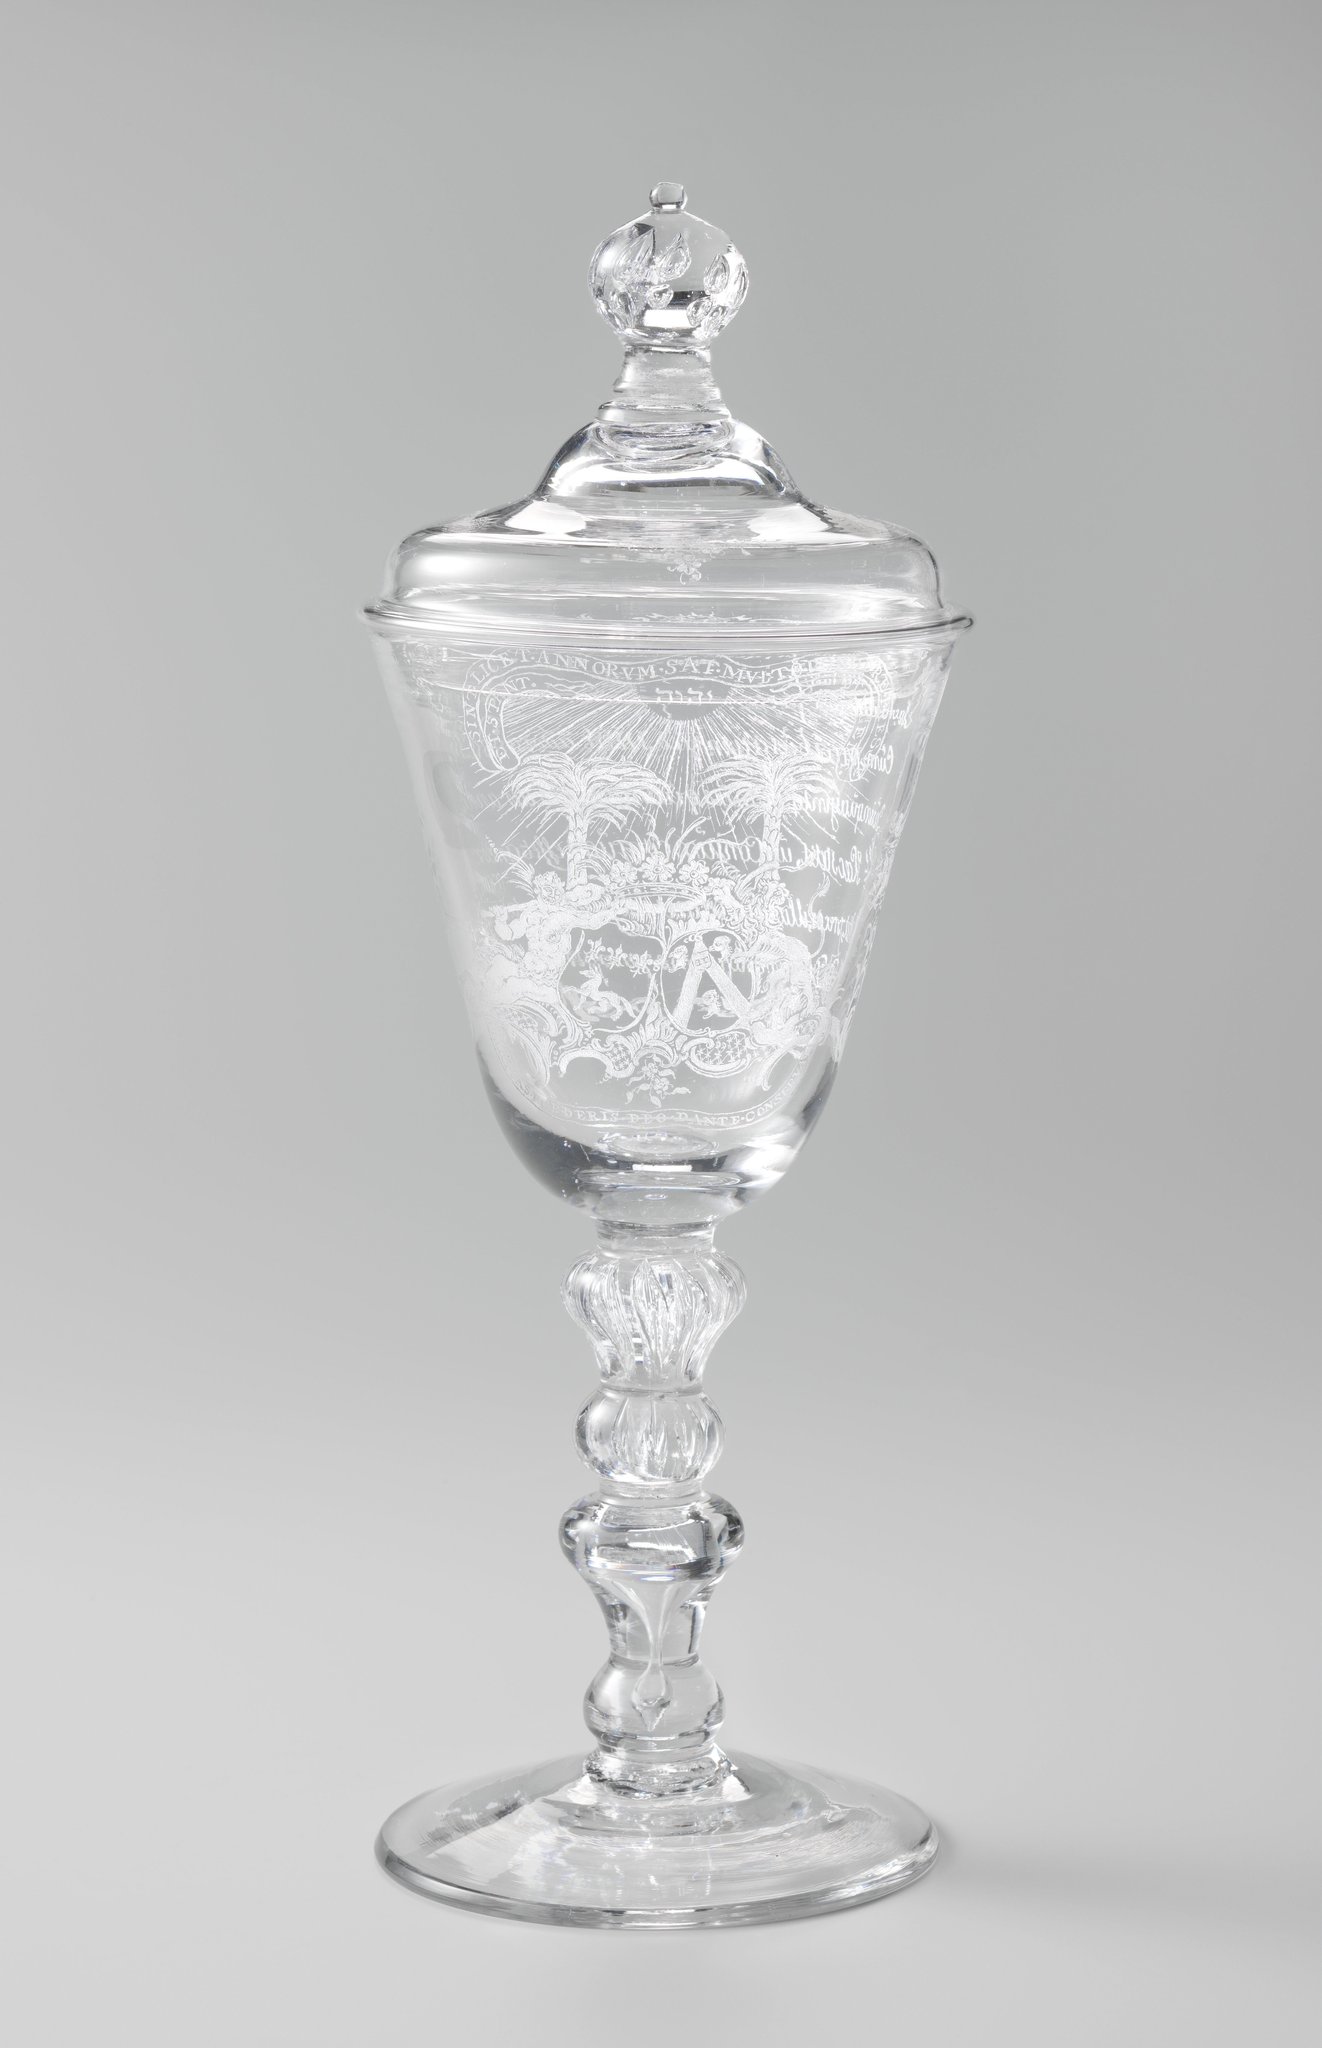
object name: goblet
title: Pair of marriage goblets with lids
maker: Anonymous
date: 1759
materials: glass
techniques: diamond point engraving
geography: northern netherlands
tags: utrecht, armorial bearing, heraldry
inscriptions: inscription: ‘Sint licet annorum sat multo podere pressae et stant et vigent / felicitas foederis deo dante conservata’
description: These goblets commemorate the fiftieth anniversary of Jan Jacob van Westrenen and Johanna Catharina Mamuchet van Houdringe. The arms were executed with a diamond-point stylus, a small diamond chip in a holder used to incise the glass. This technique was common in the Netherlands in the 17th century. Translation of inscription A: Best wishes and good cheer oh Noble couple on your Fiftieth Wedding Year. Translation of inscription B: Despite the burden of so many years,